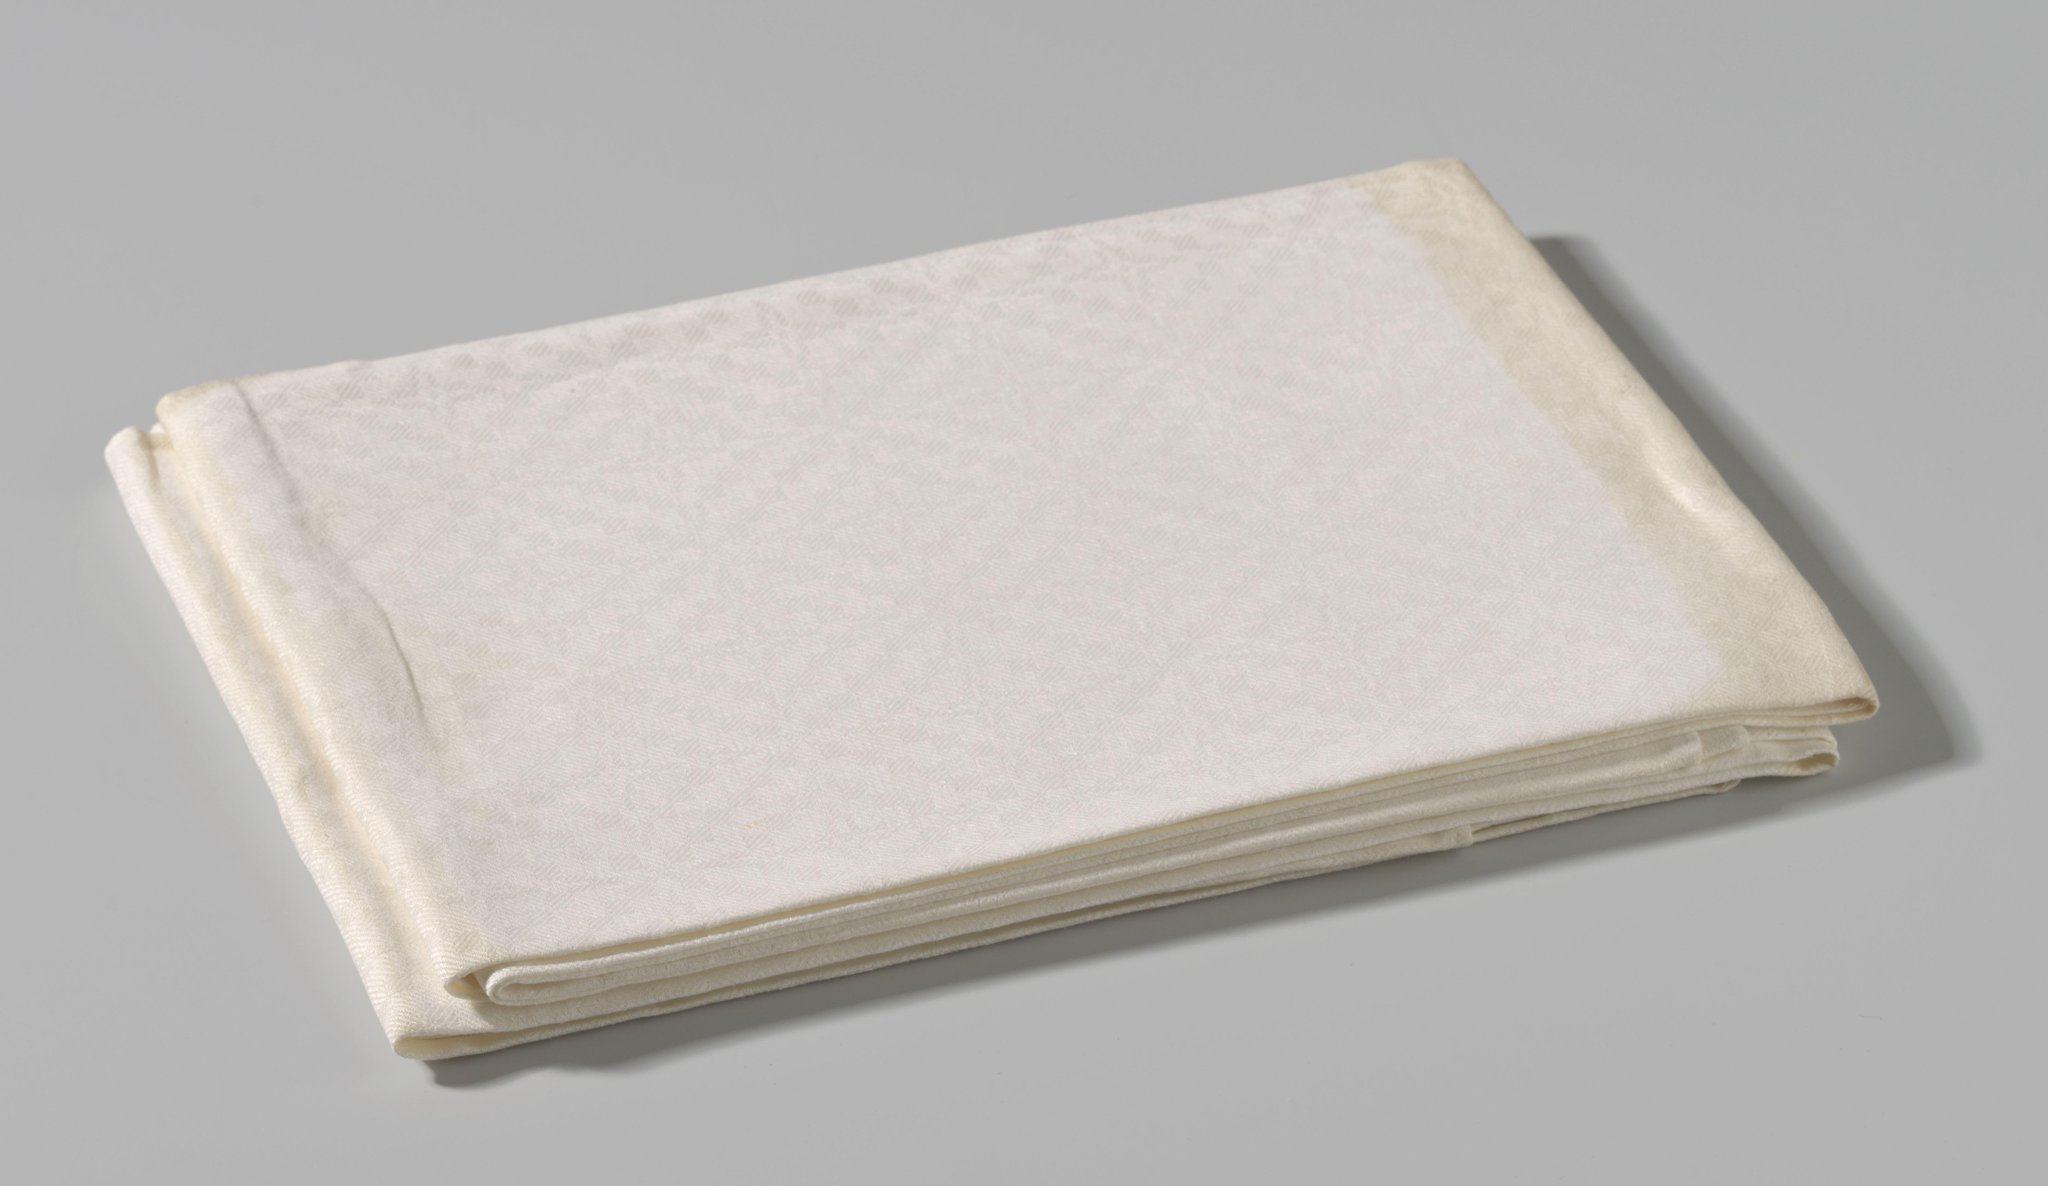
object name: tablecloth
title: Fragment, pellen met patroon 'molenwiek'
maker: Anonymous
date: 1600-1675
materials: linen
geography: northern netherlands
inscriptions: mark: ‘K’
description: Tafellaken van wit linnen met een pellenpatroon in keper z.g. 'molenwiek', merk K.